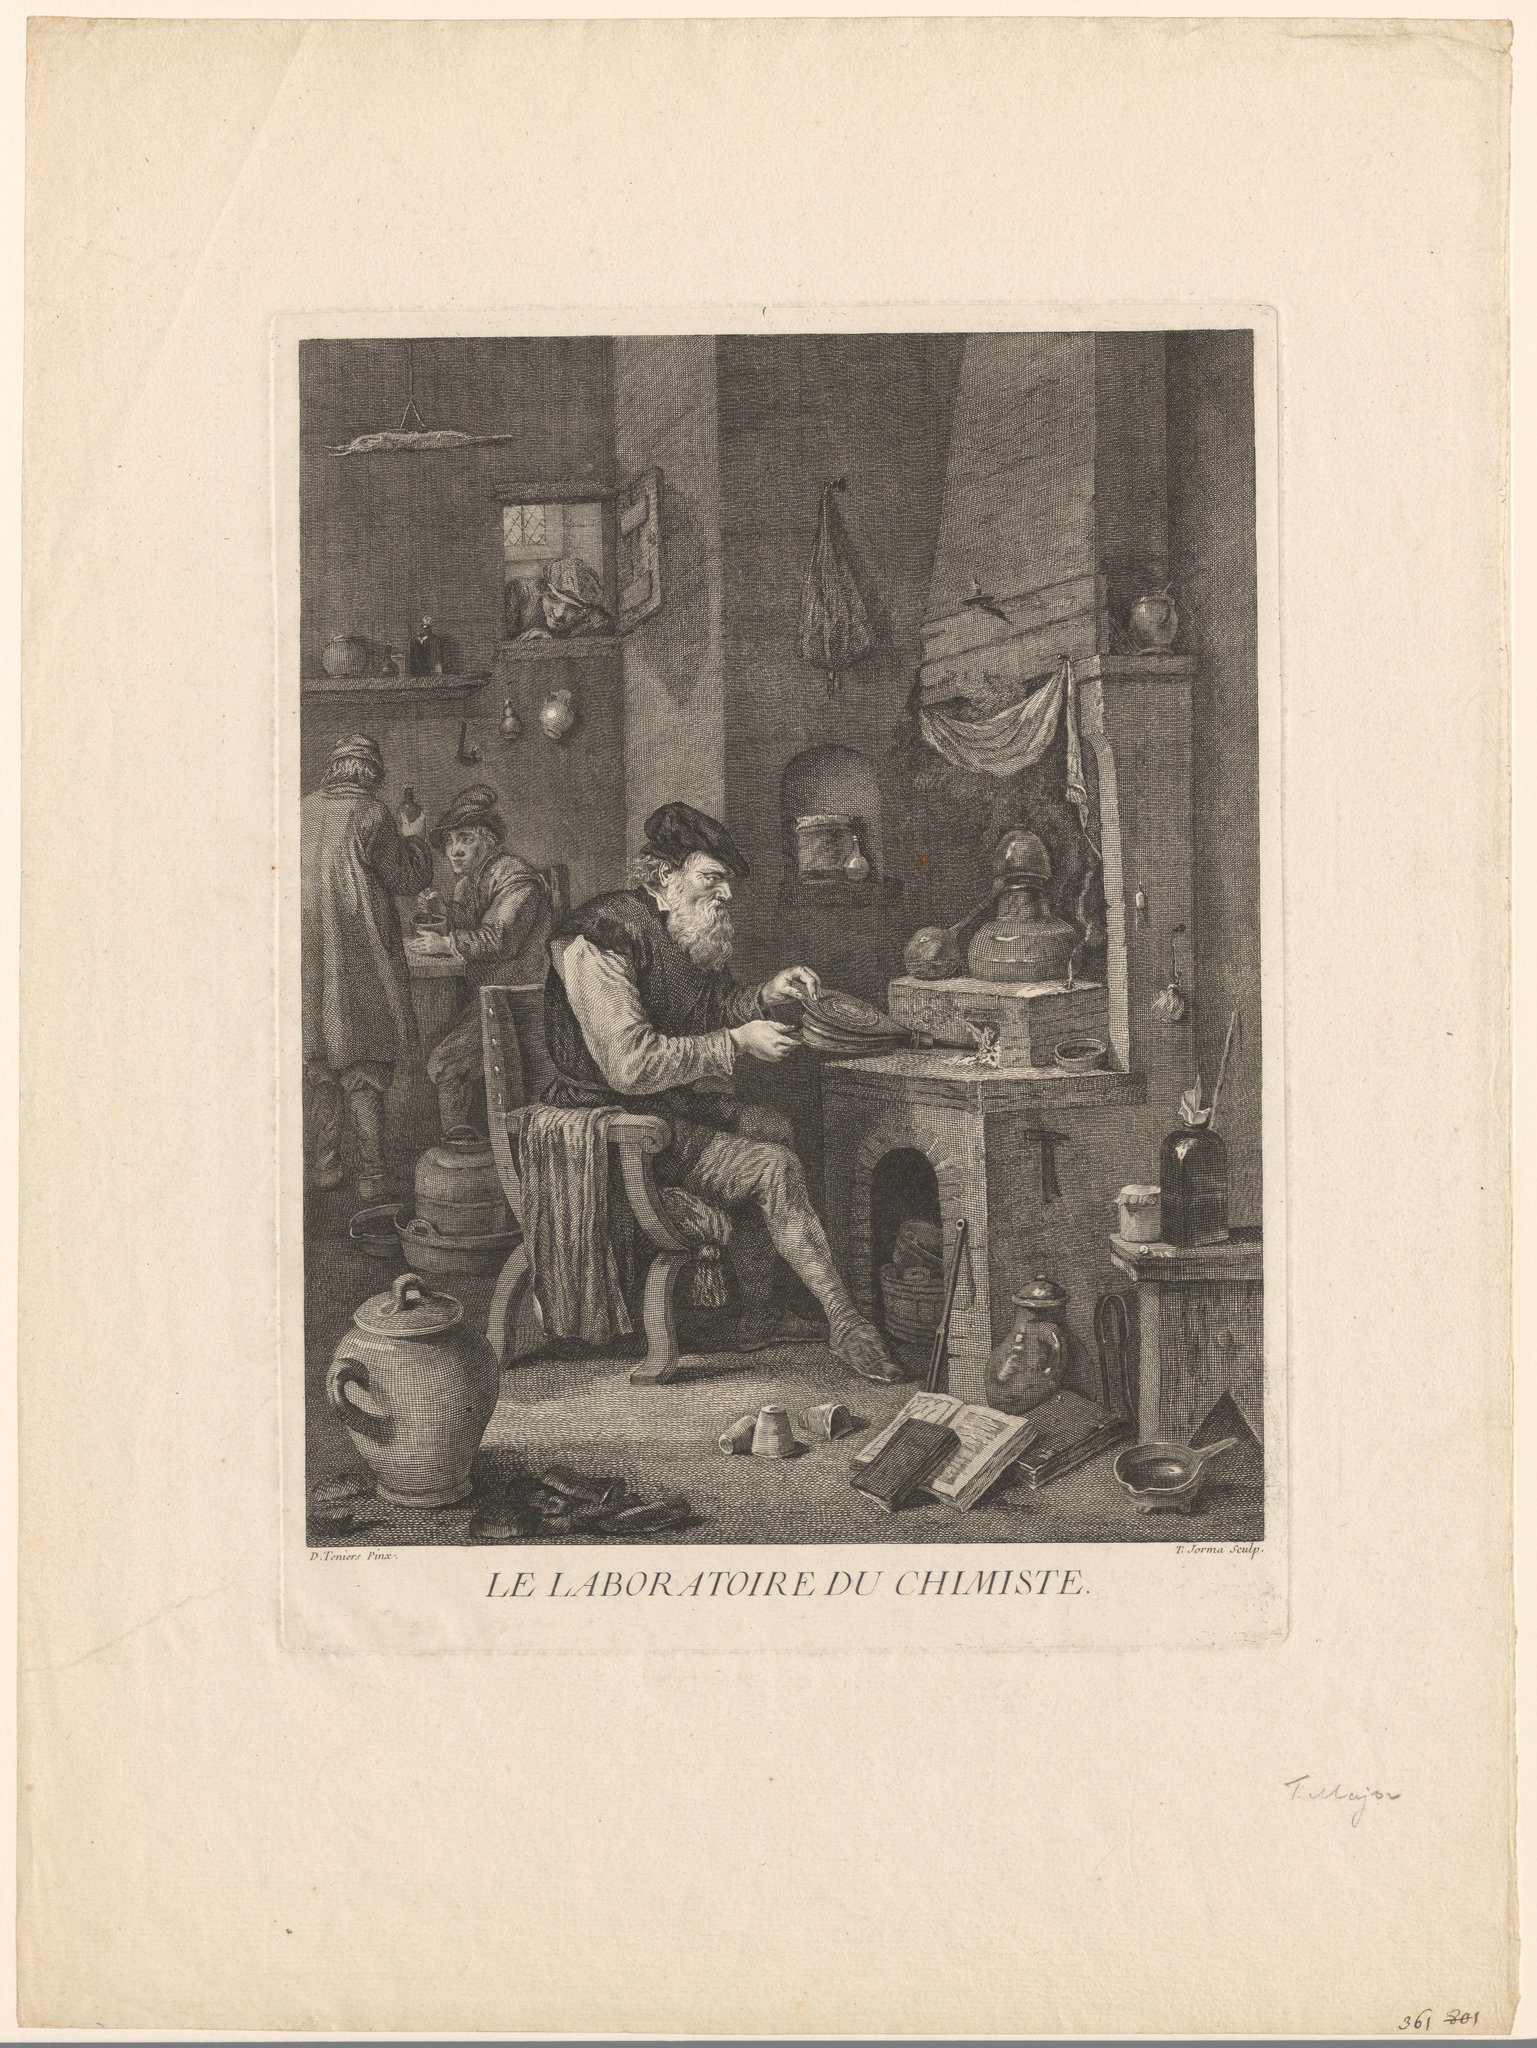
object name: print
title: Alchemist aan het werk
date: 1755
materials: paper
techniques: etching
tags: alchemist at work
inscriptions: collector's mark: Lugt 2228